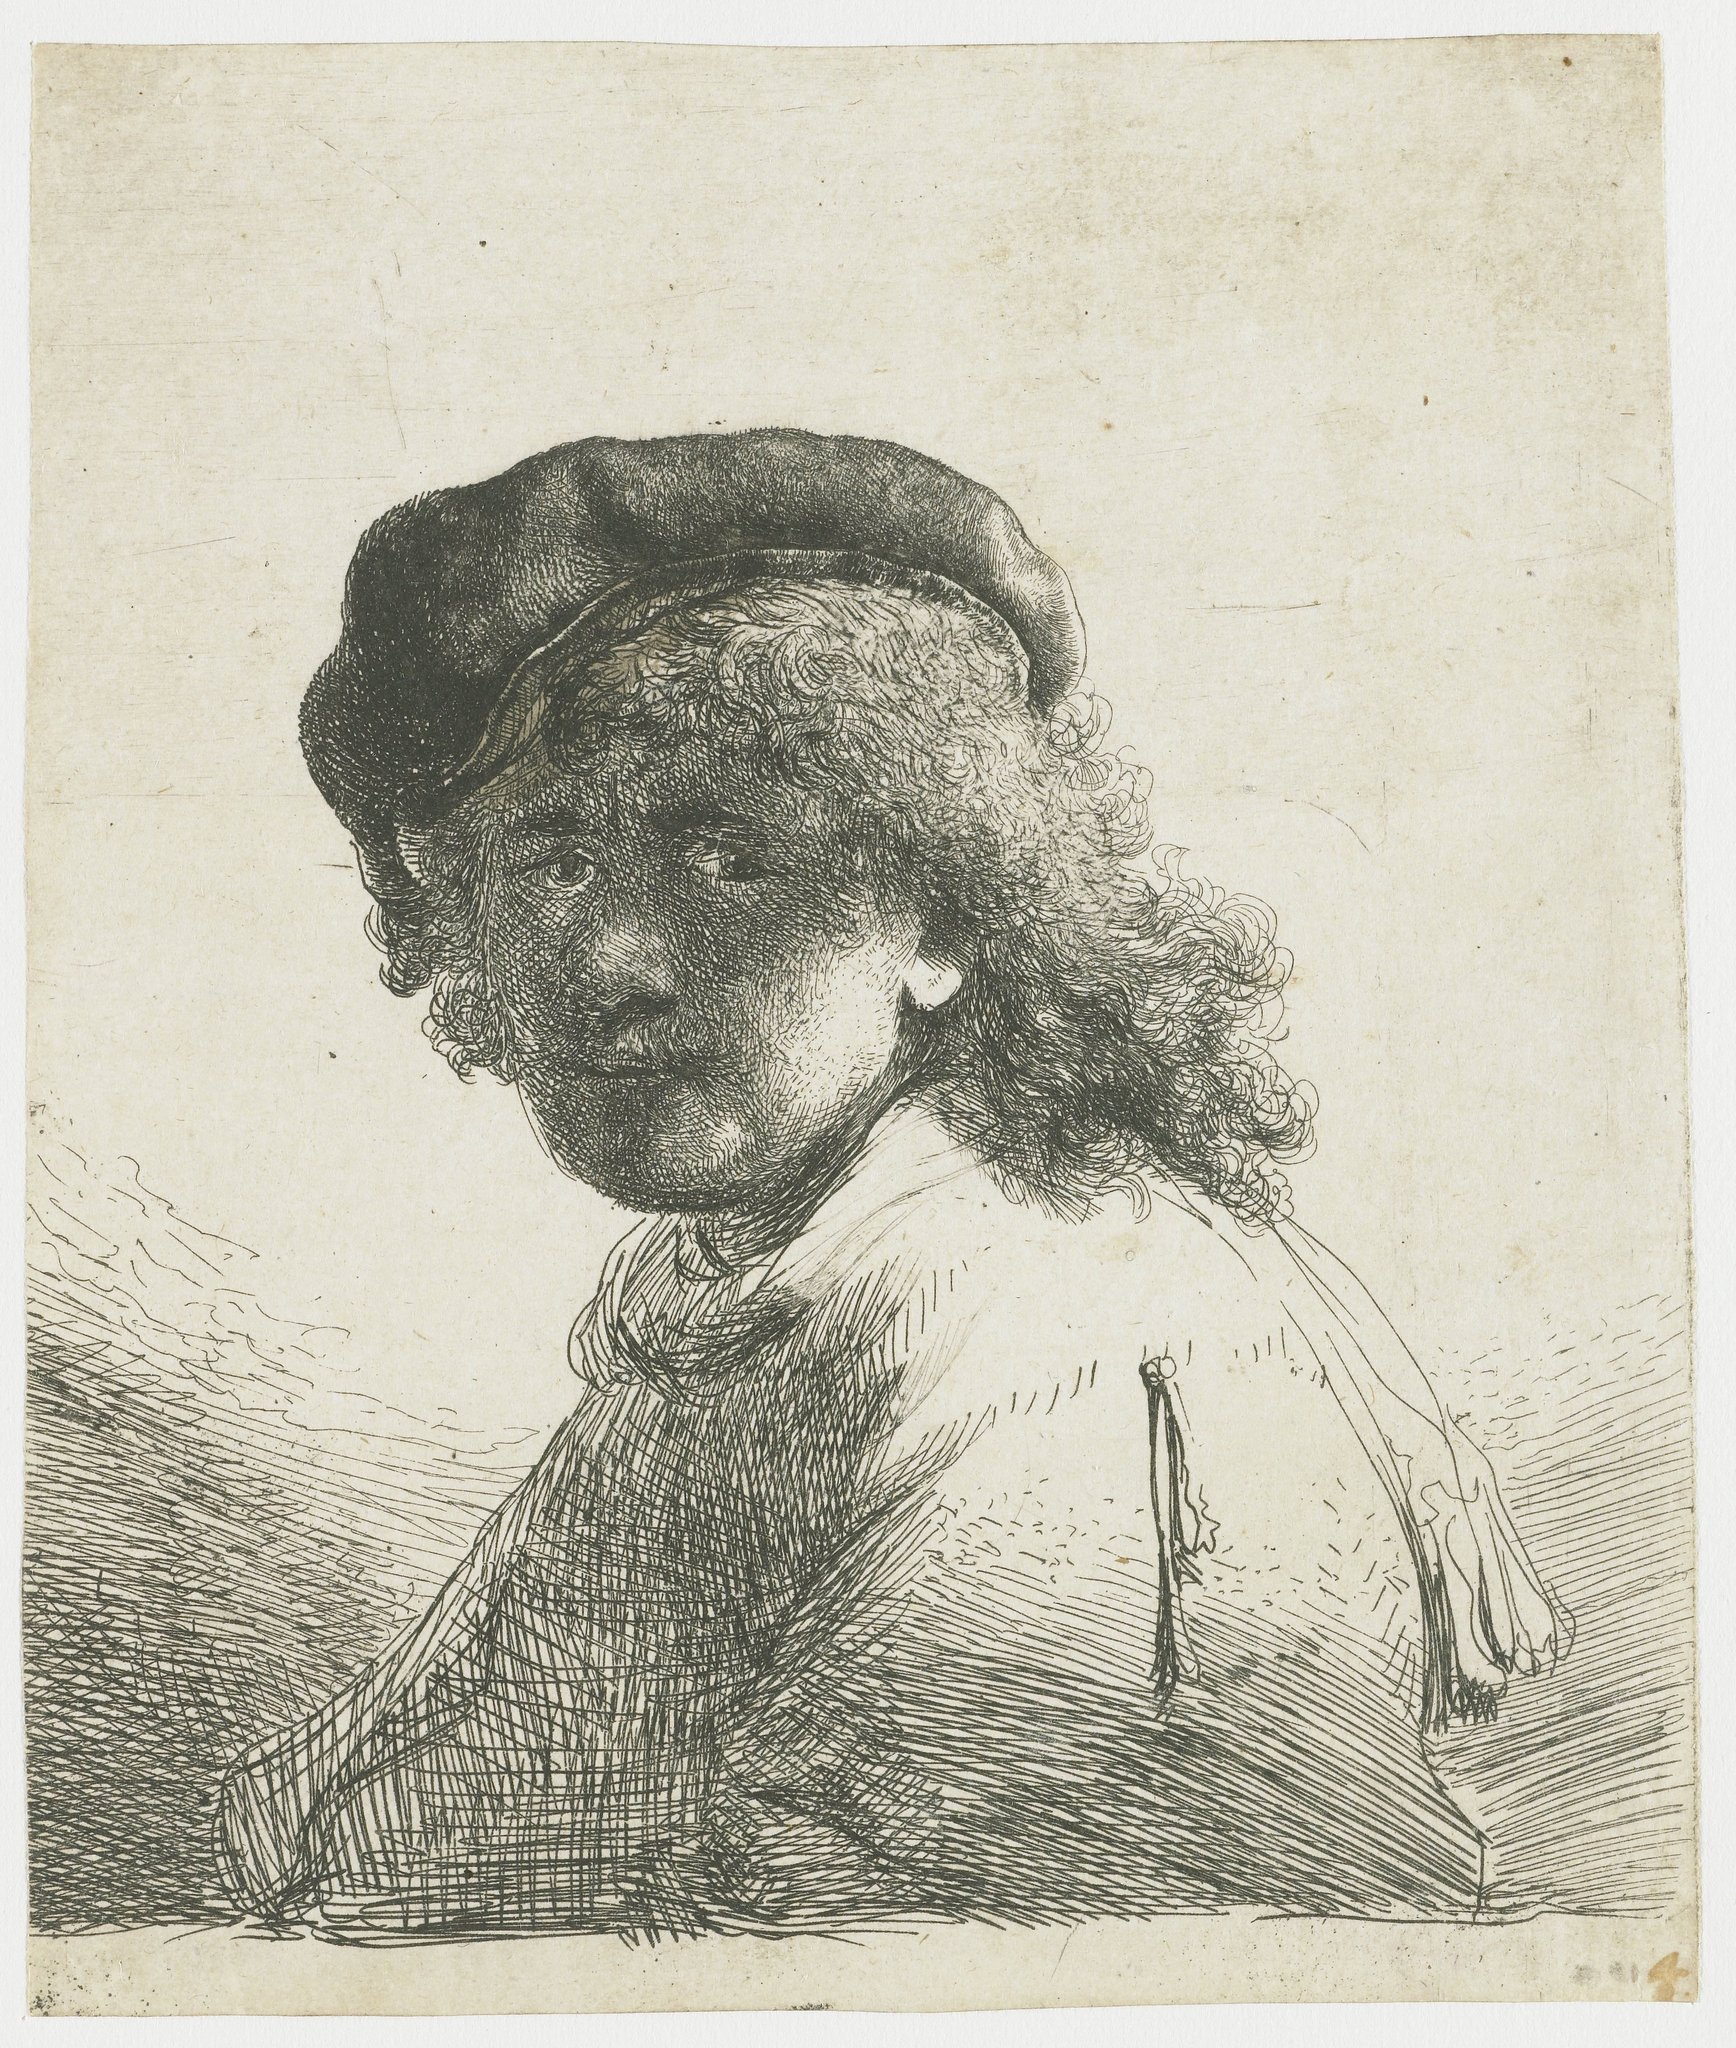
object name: print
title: Self-portrait in a cap and scarf with the face dark: bust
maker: rembrandt van rijn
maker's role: draughtsman, painter, print maker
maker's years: 1606-1669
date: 1633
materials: paper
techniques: brush, etching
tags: leiden, amsterdam, print maker, draughtsman, rembrandt van rijn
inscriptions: collector's mark: Lugt 240